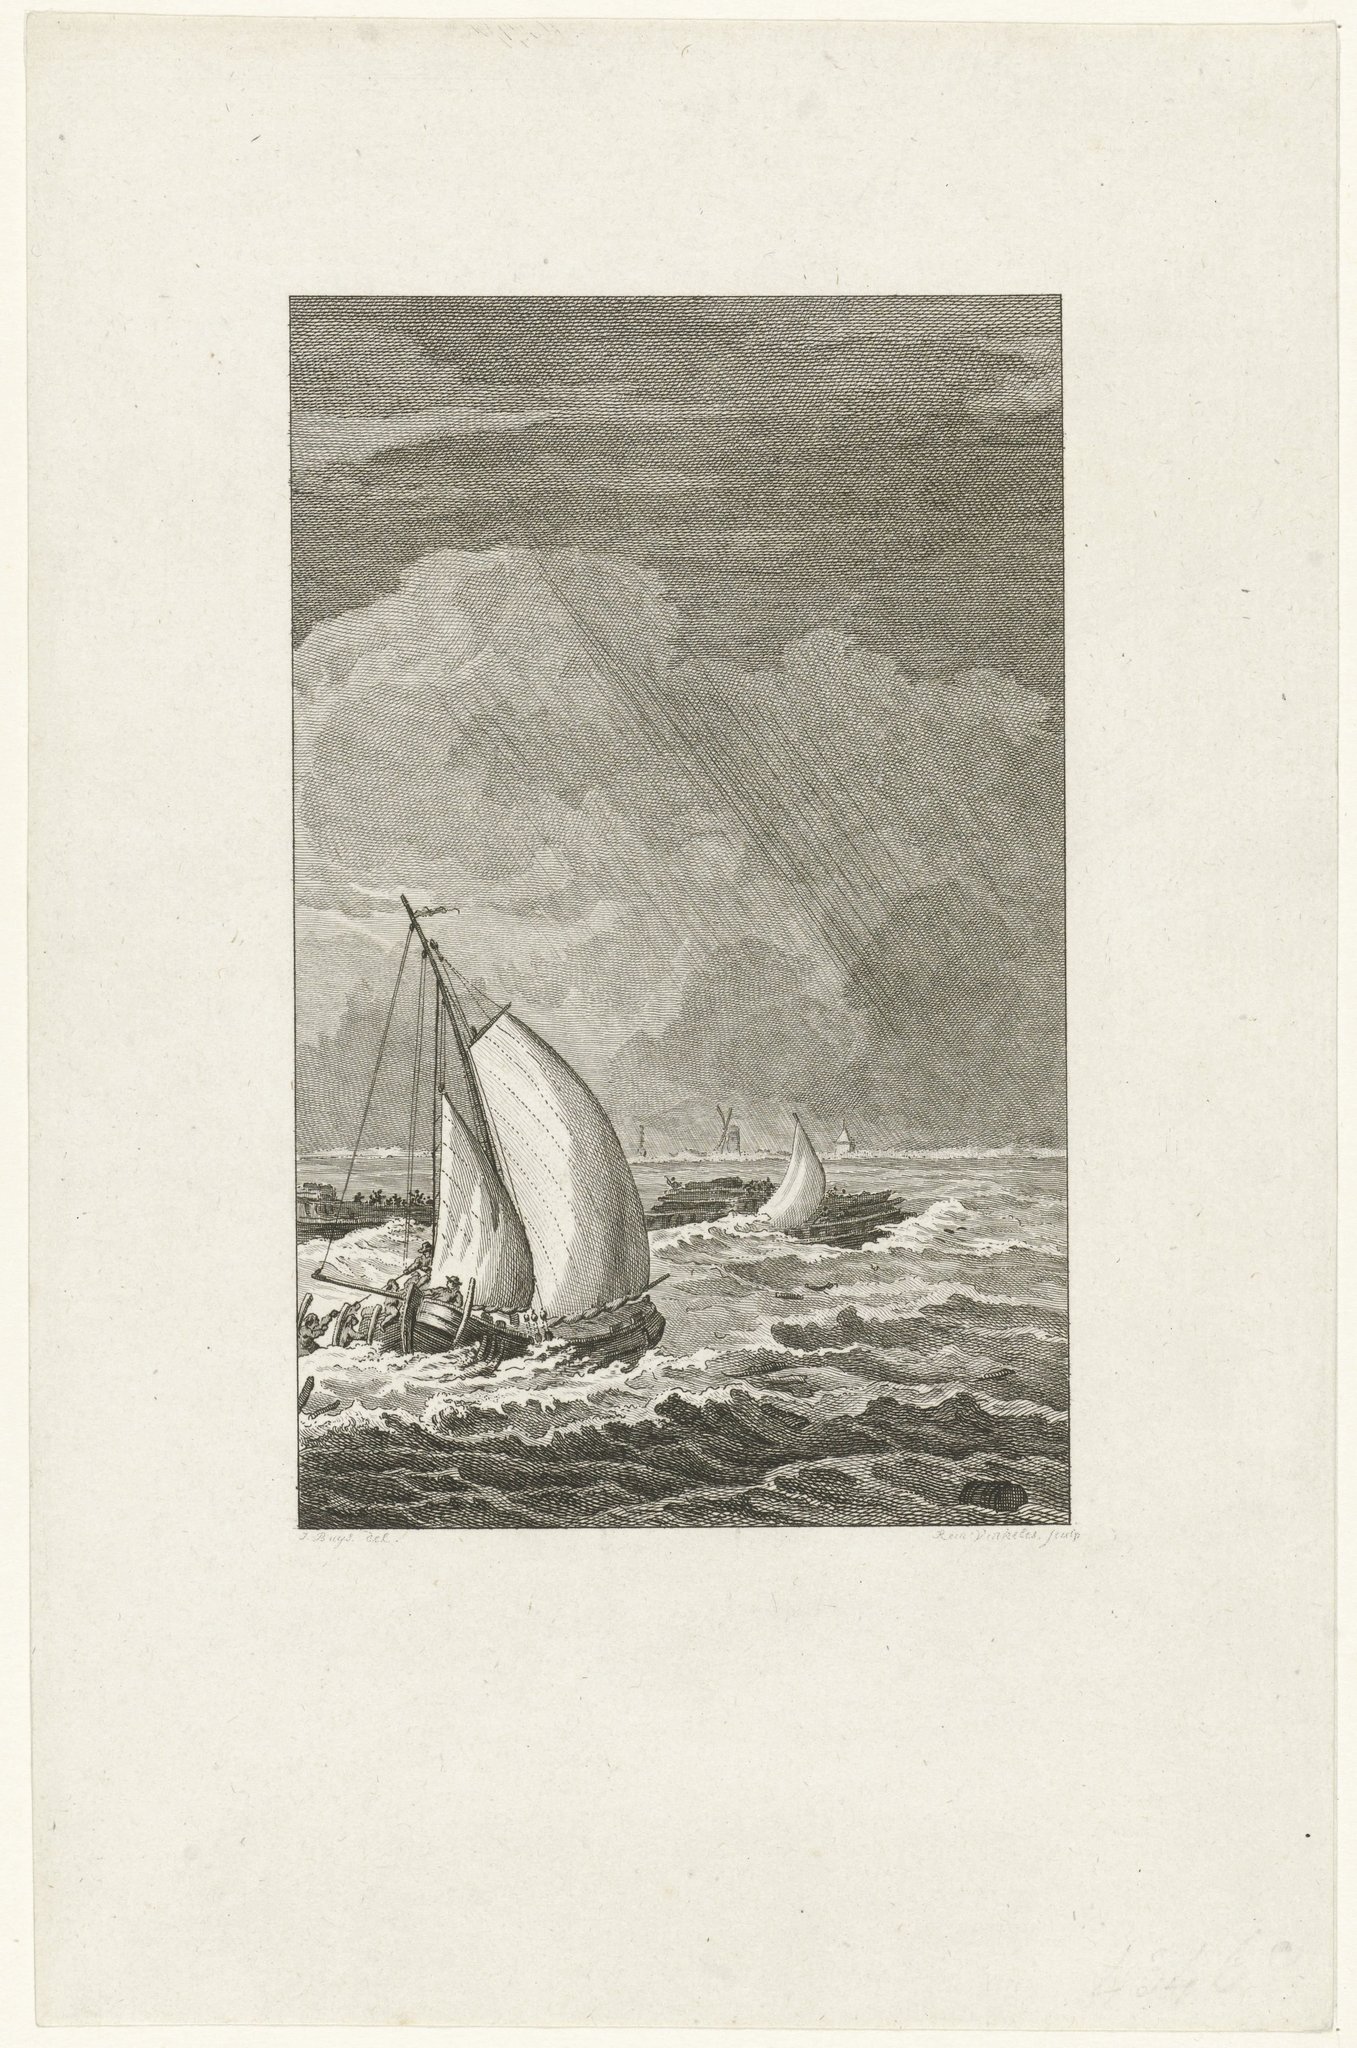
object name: print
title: Gebroeders Naerebout redden de opvarenden van de Woestduin, 1779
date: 1787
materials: paper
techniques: engraving, etching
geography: northern netherlands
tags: shipwreck (+ saving the victims ~ traffic accident)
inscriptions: collector's mark: Lugt 2228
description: Gebruikt als illustratie in: P.A. Loosjes. Vaderlandsche historie, vervattende de geschiedenissen, der Vereenigde Nederlanden (...). Ten onmiddelyken vervolge van Wagenaar's Vaderlandsche historie. Amsterdam: J. Allart.